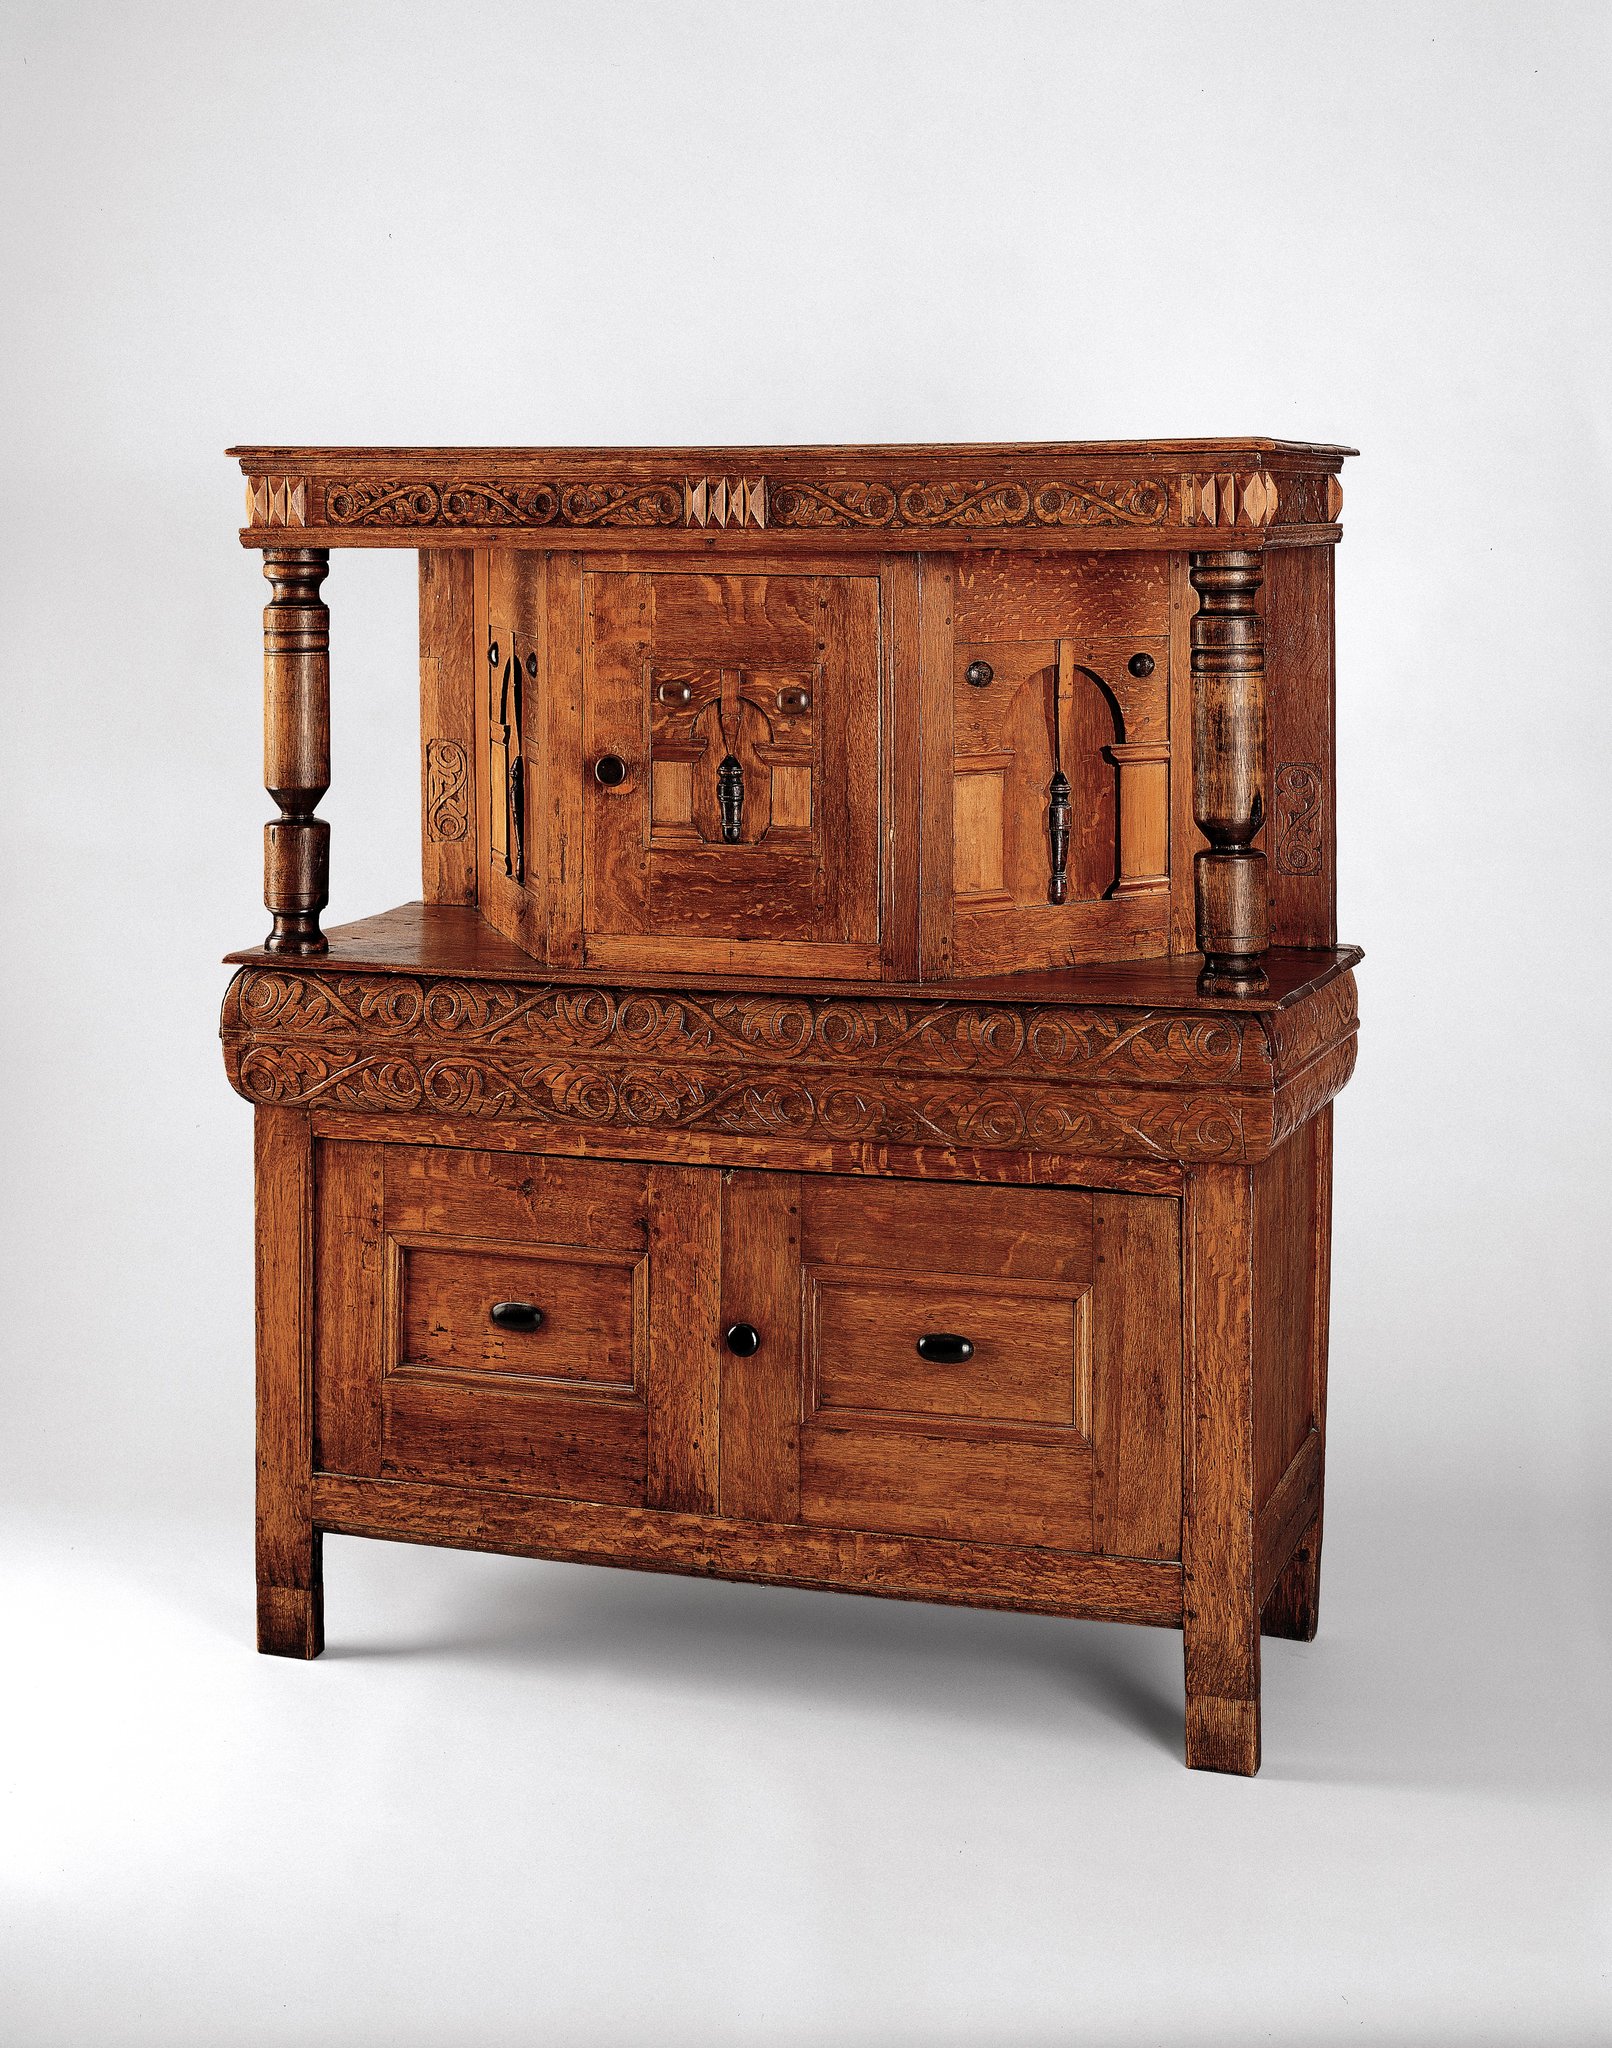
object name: cupboard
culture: american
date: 1670-1700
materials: wood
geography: united states